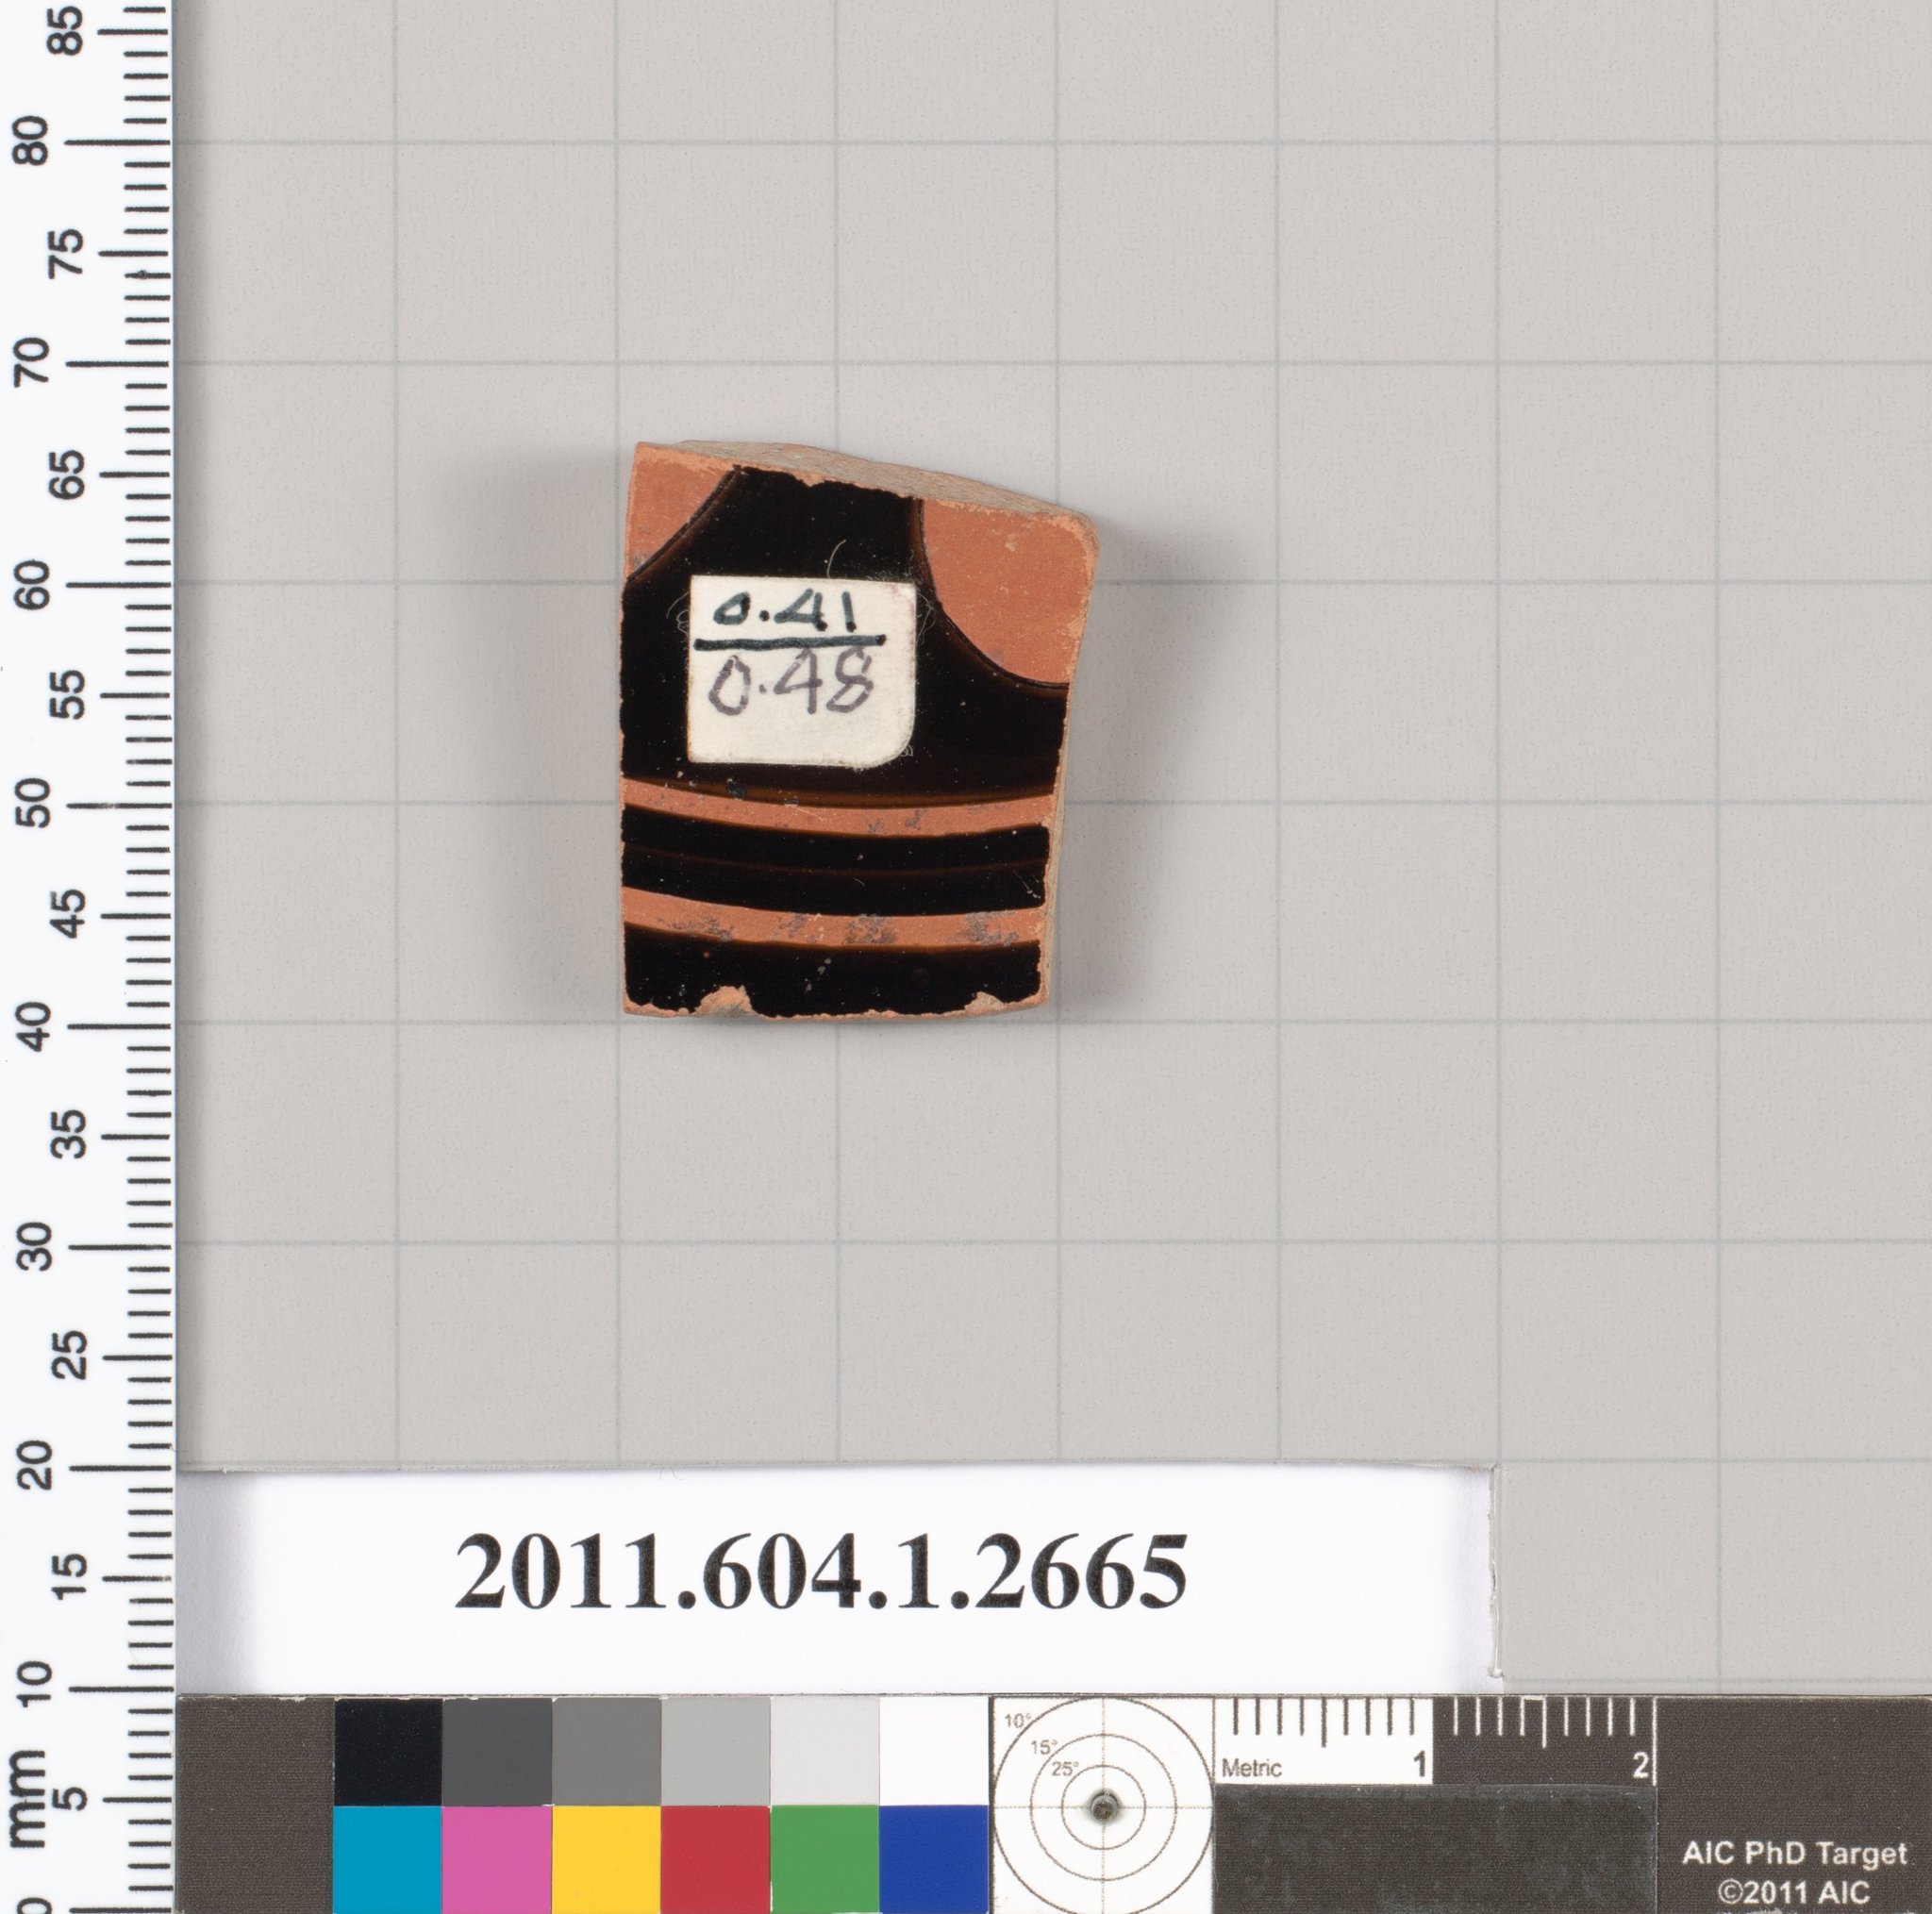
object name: kylix fragment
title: Terracotta fragment of a kylix (drinking cup)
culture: greek, attic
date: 500-451 BCE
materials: terracotta